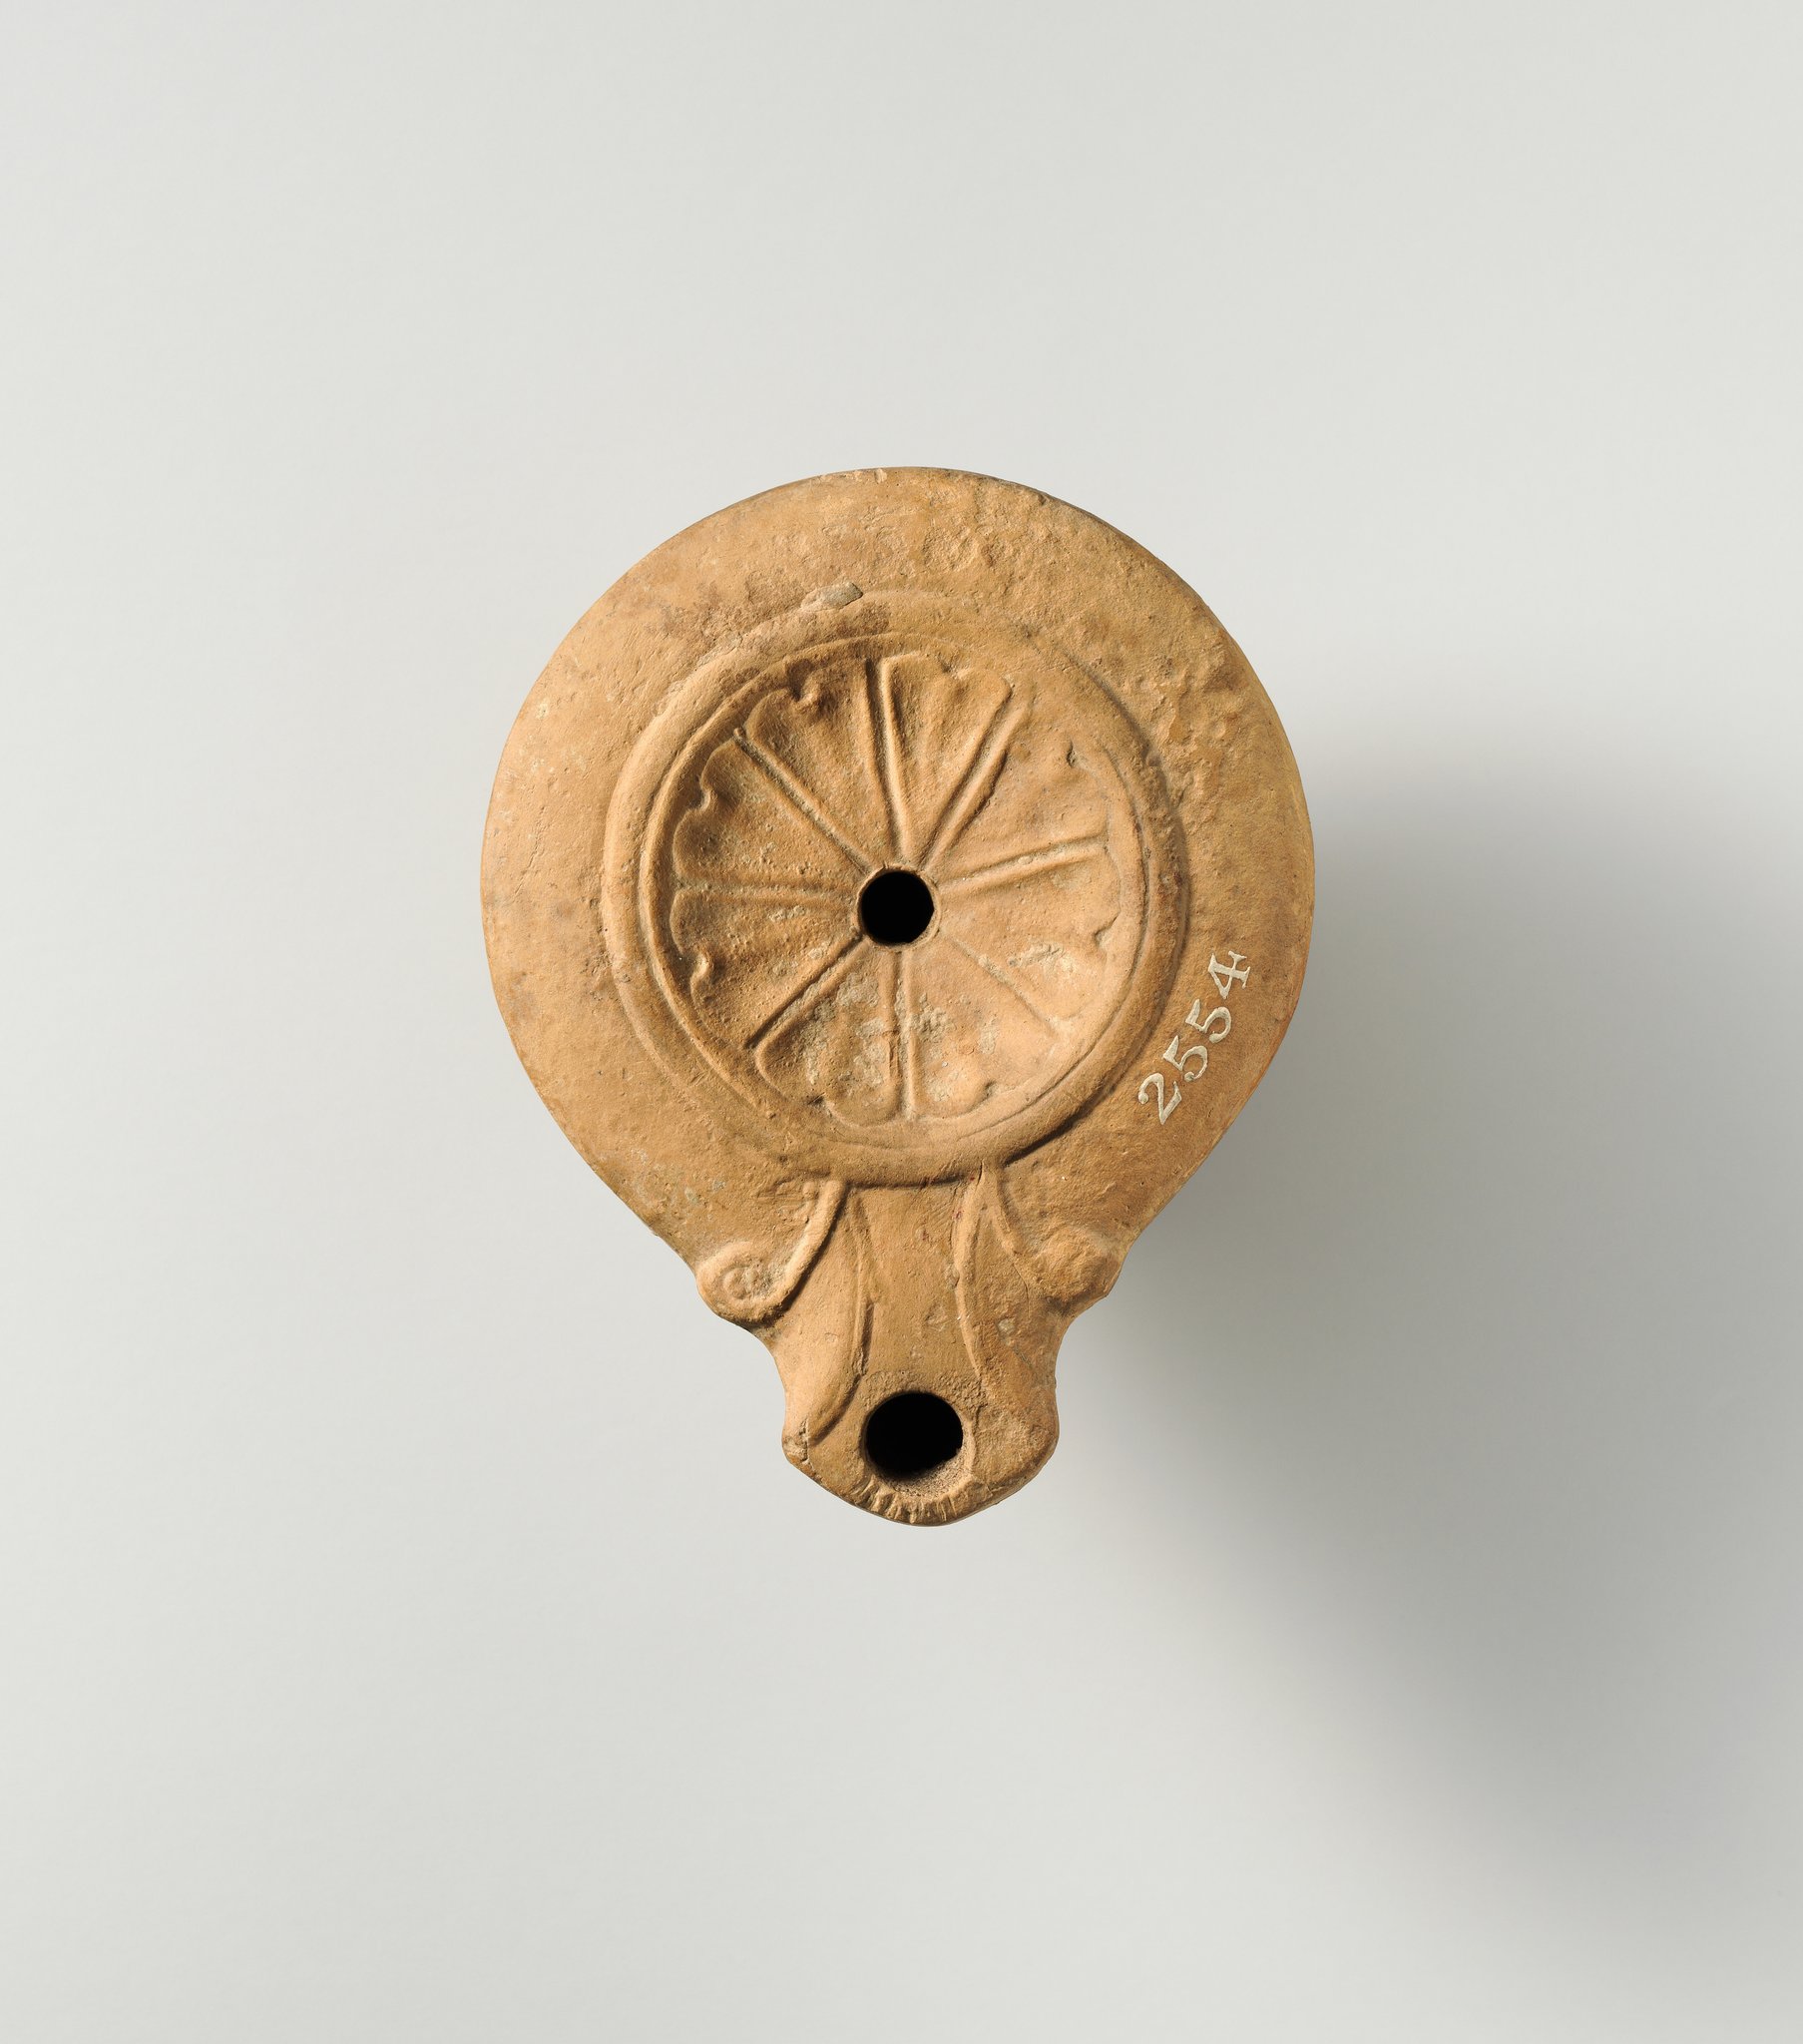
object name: lamp, concave top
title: Terracotta oil lamp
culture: roman, cypriot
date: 100 BCE-100 CE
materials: terracotta